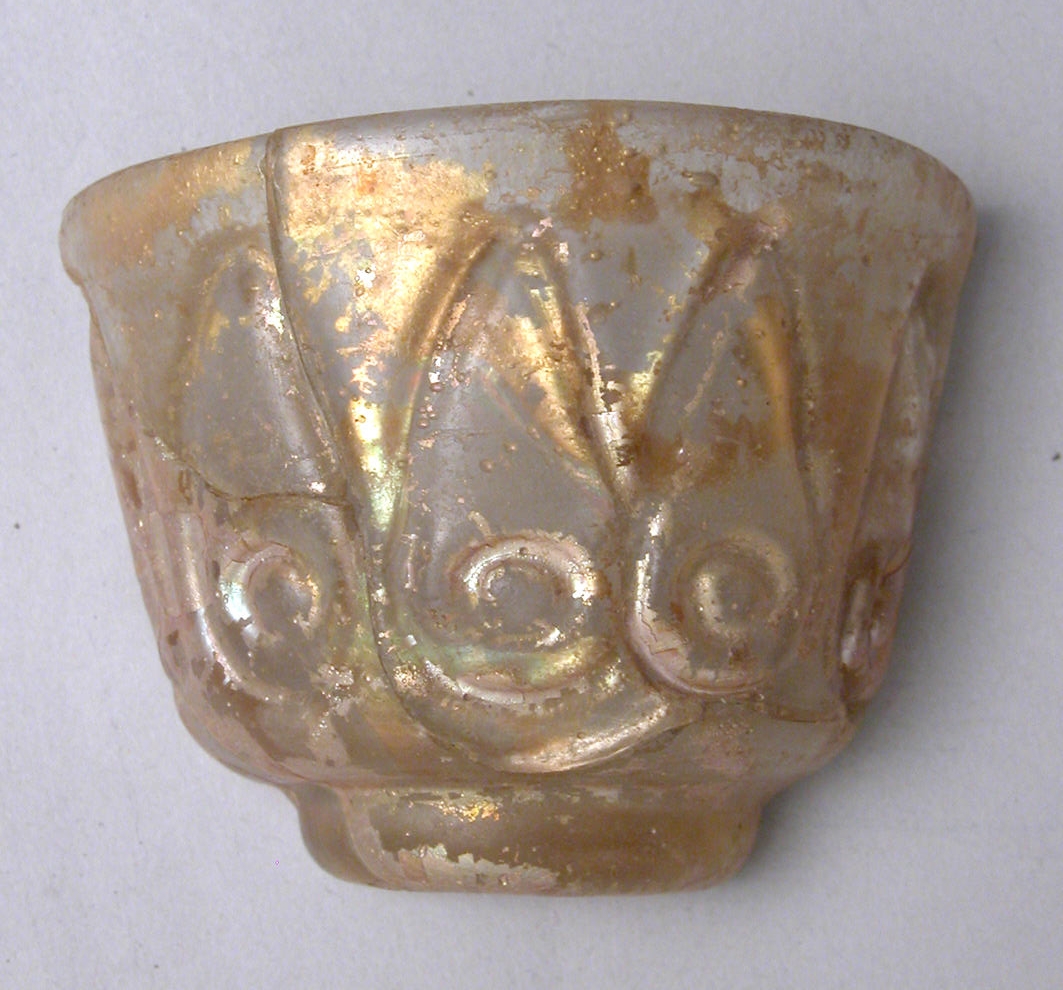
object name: cup, fragment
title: Fragmentary Cup with Molded Designs in the Beveled Style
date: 801-900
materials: glass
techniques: glassblowing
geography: iraq